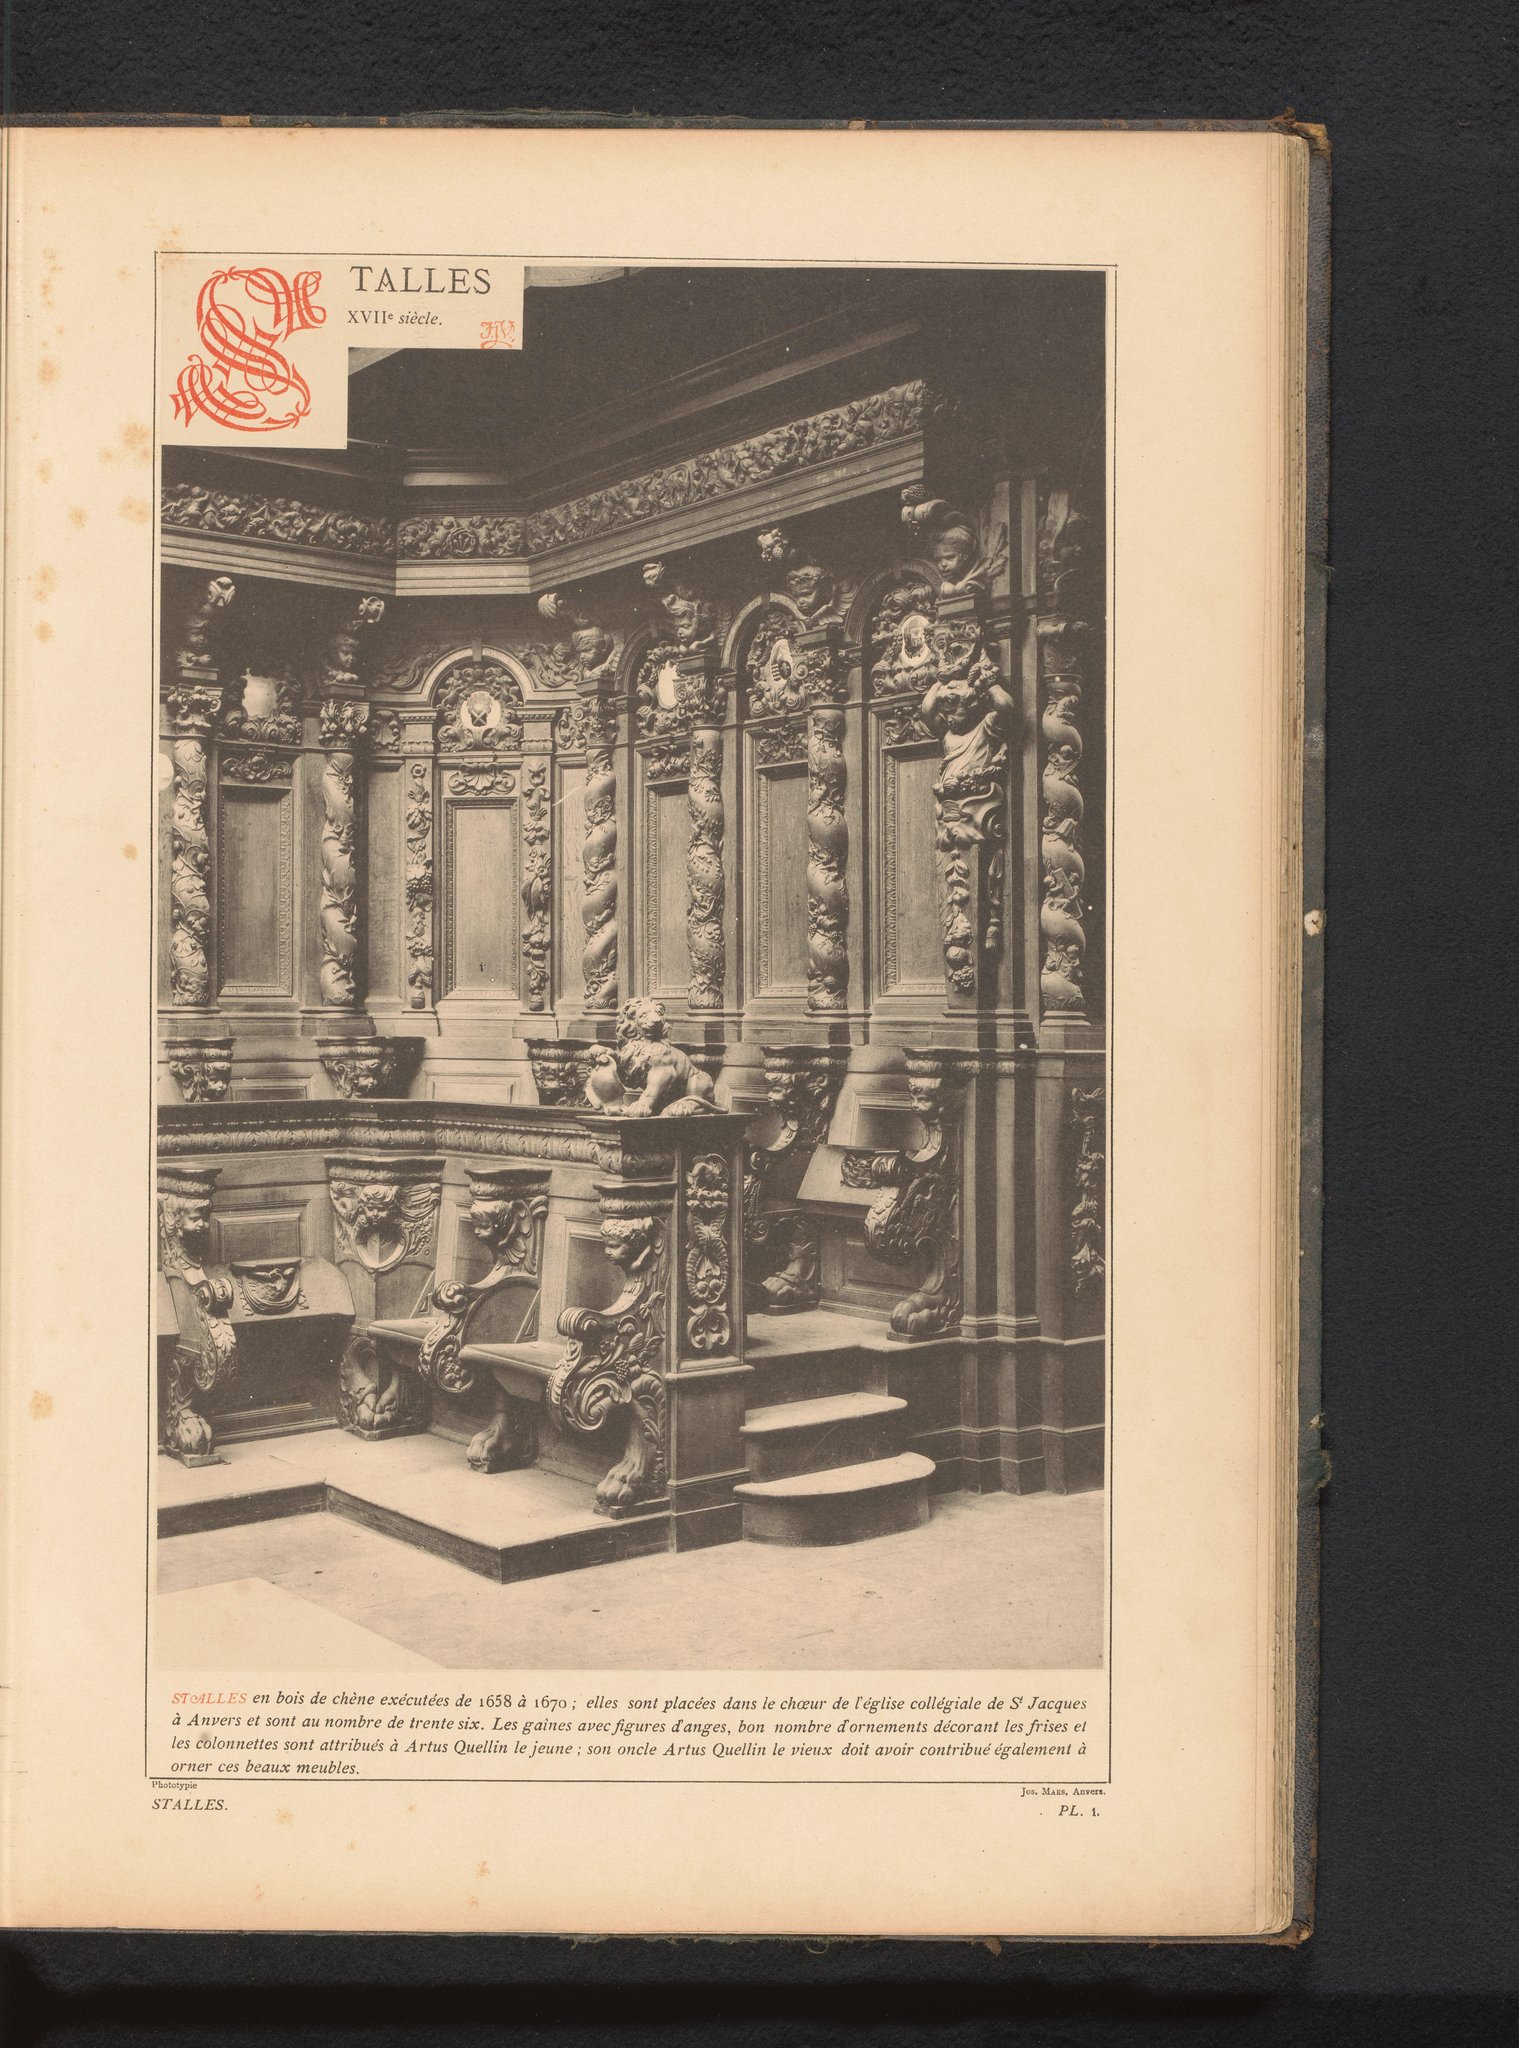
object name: photomechanical print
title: Stalles, XVIIe siècle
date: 1882-1887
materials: paper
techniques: photograph, photolithography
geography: antwerpen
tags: bench, parts of church interior: choir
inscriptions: inscription: ‘STALLES en bois (...)’, inscription: ‘STALLES. - PL. 1.’, monogram: ‘JJvY’